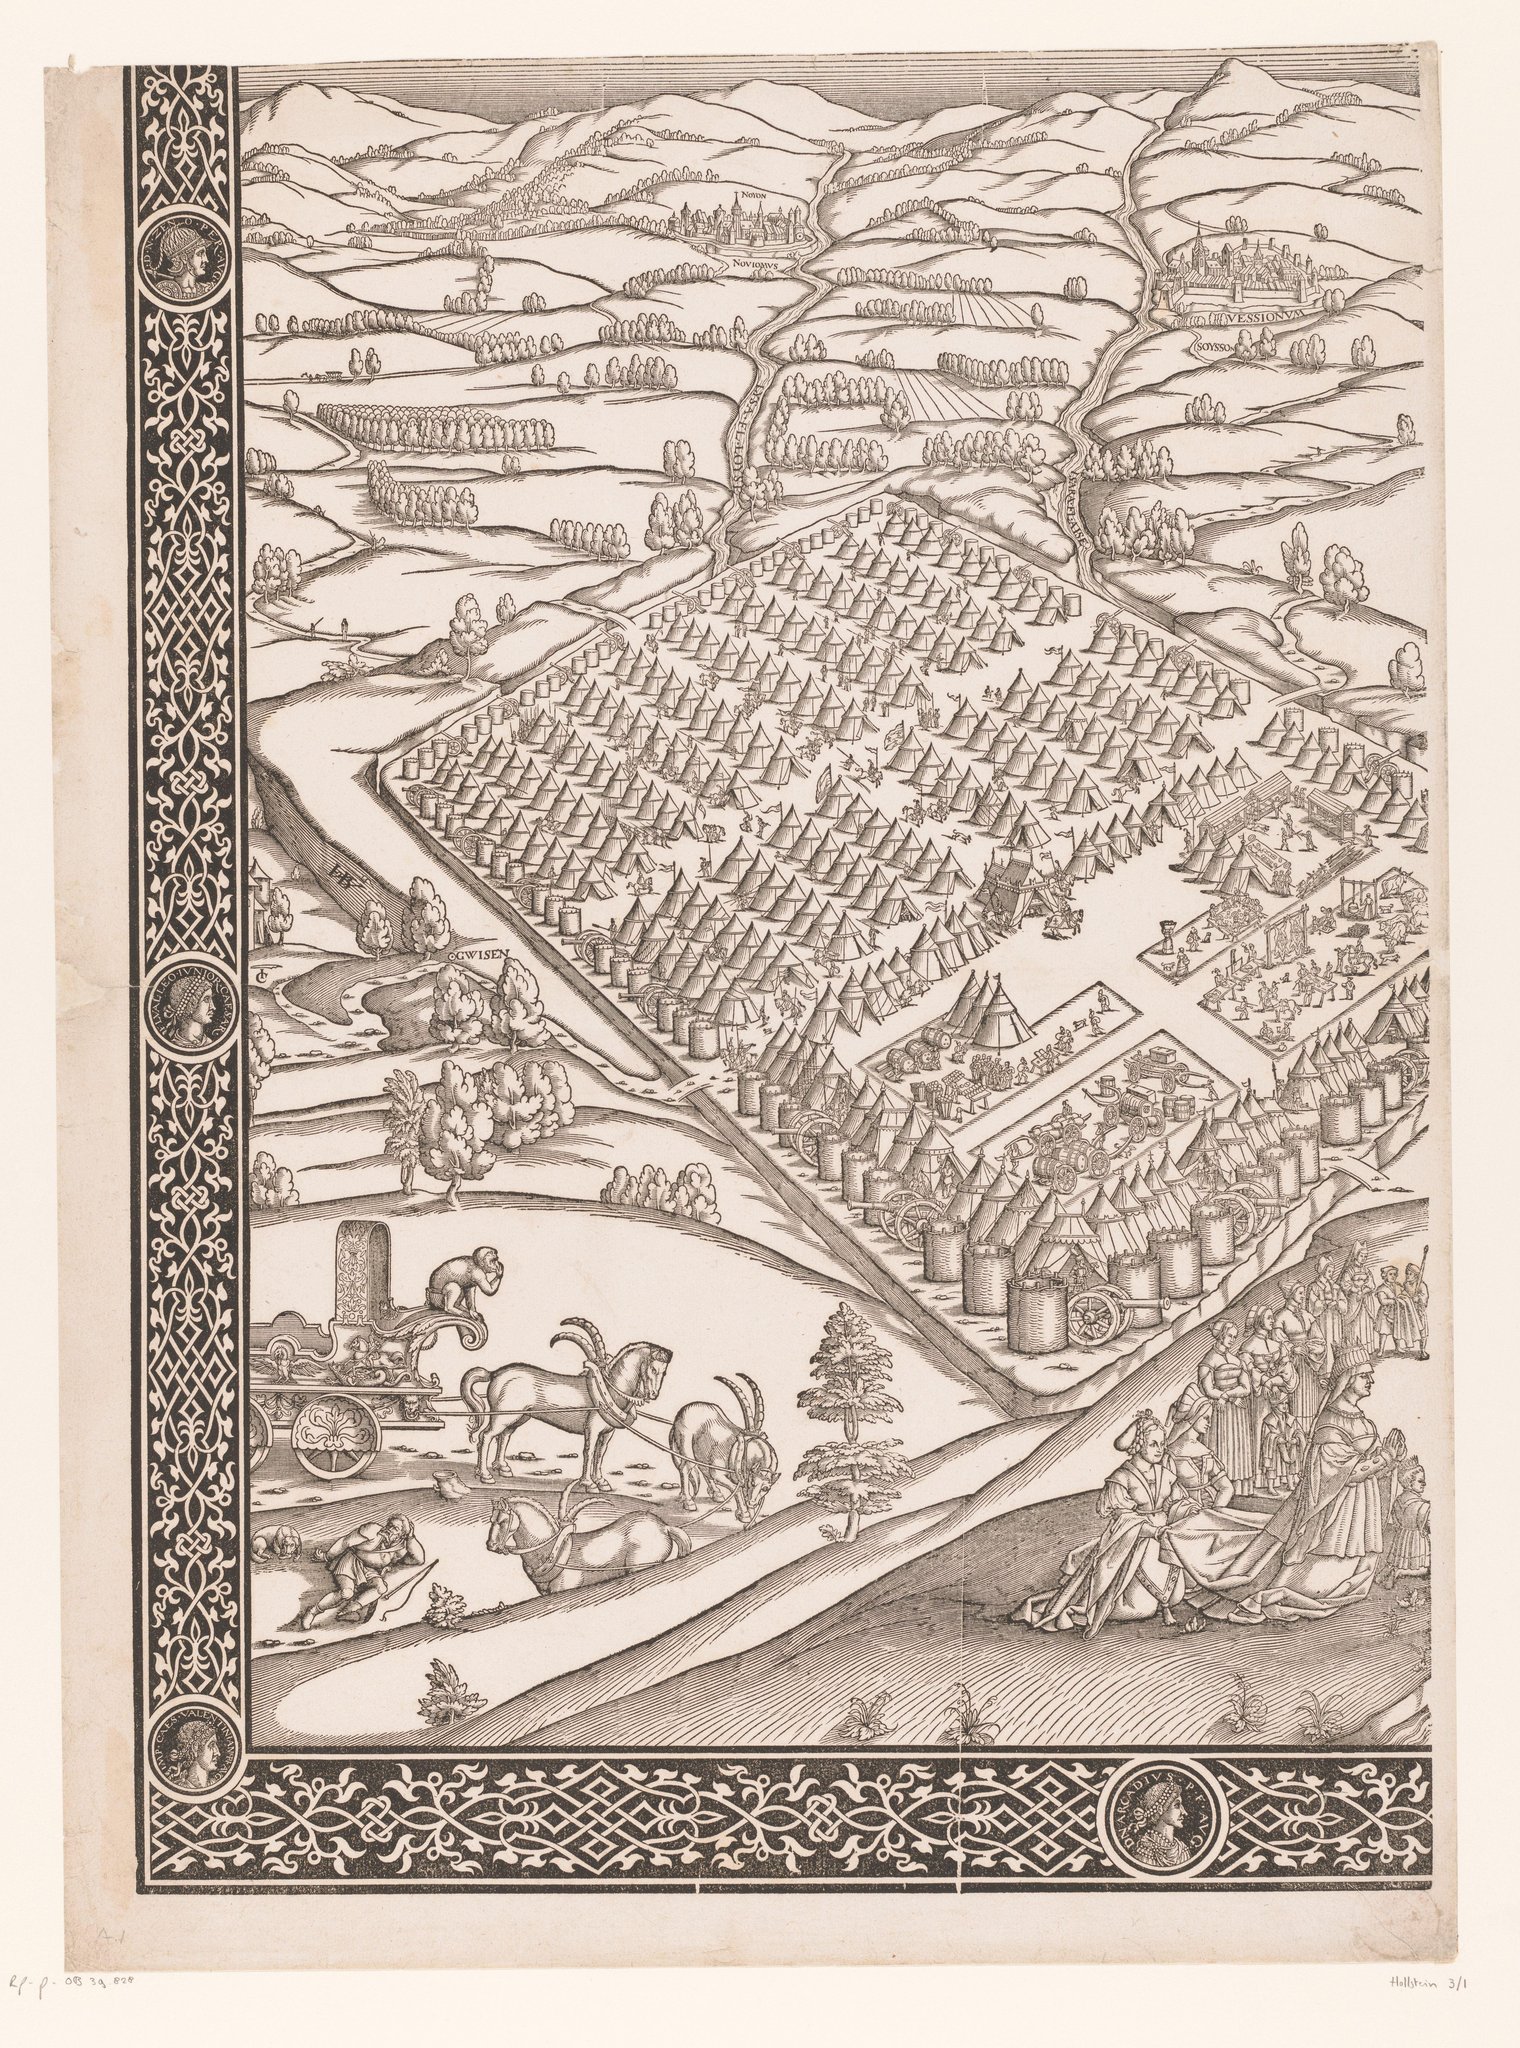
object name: print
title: Stamboom van Frederik en Ottheinrich van Palts-Neuburg (plaat 1)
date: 1535-1594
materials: paper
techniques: woodcut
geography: basel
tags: family lineage, pedigree, genealogical tree or table, cologne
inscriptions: collector's mark: Lugt 240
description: Blad 1 van een stamboom bestaande uit 21 bladen, gedrukt van 42 blokken.